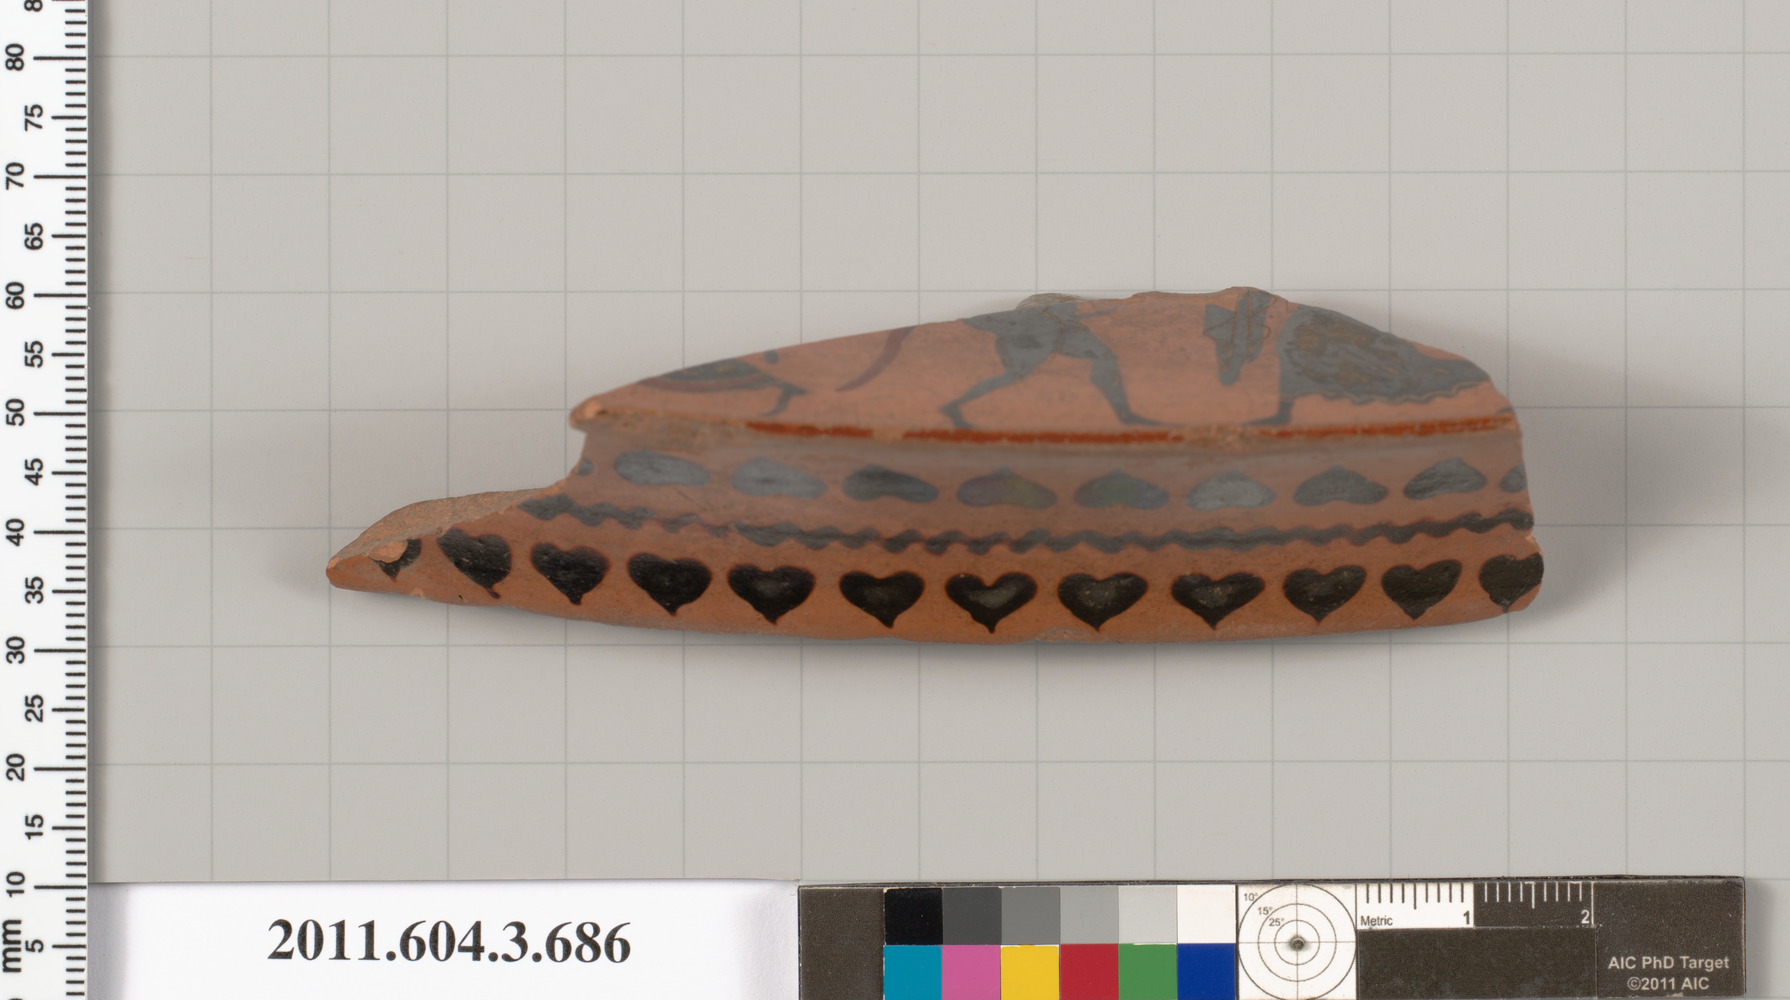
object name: column krater or dinos fragment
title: Terracotta fragment of a dinos or column-krater (bowl for mixing wine and water)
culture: greek, attic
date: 550-526 BCE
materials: terracotta